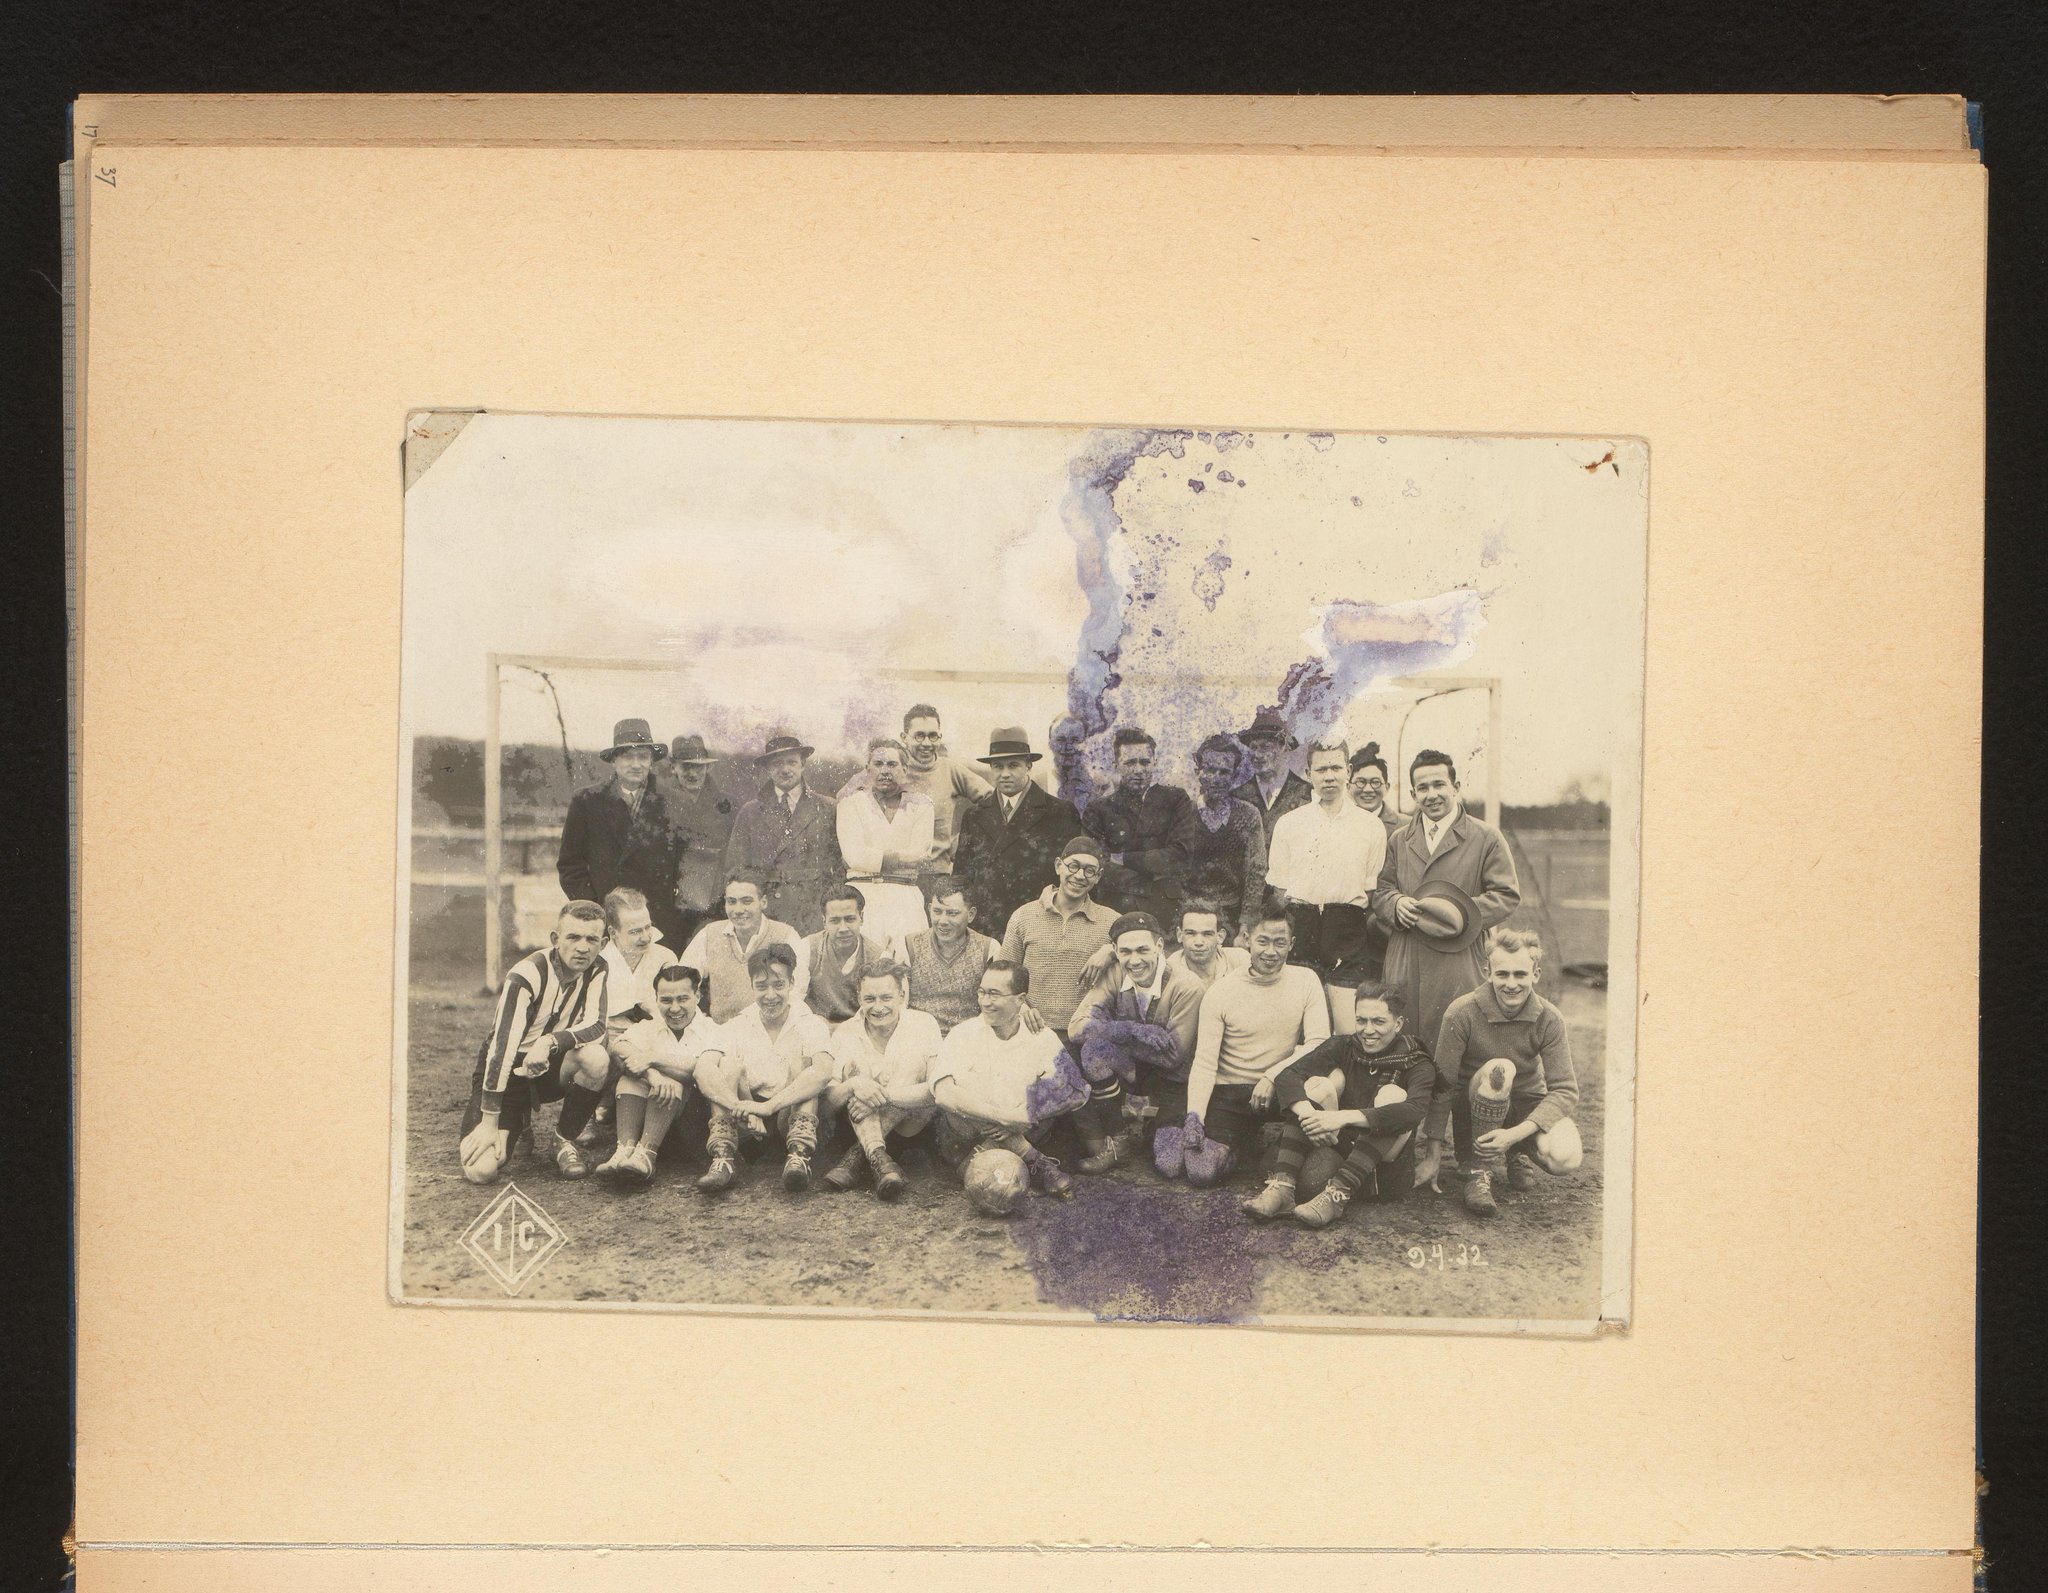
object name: album leaf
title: Voetbalelftal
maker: Anonymous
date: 1932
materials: cardboard, photographic support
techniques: gelatin silver print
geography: netherlands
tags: surabaya, paris, beatrice jacqueline eveline dumas, soccer, football (early names: soule, choule, cholle) (+ sportsman, player, etc.), netherlands, dutch east indies, the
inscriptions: date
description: Blad met een groepsfoto van de spelers van een voetbalelftal, linksonder het symbool met de letters IC. Mogelijk is Han, de broer van Eef, een van de spelers. Onderdeel van het fotoalbum van Beatrice Jacqueline Eveline (Eef) Dumas, ca. 1880-1952.